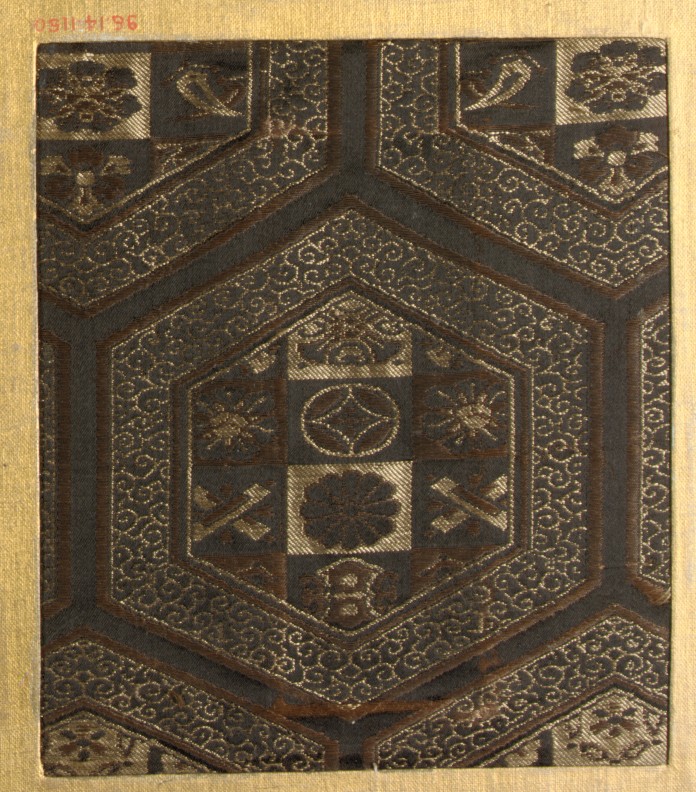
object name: piece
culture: japanese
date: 1701-1900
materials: silk